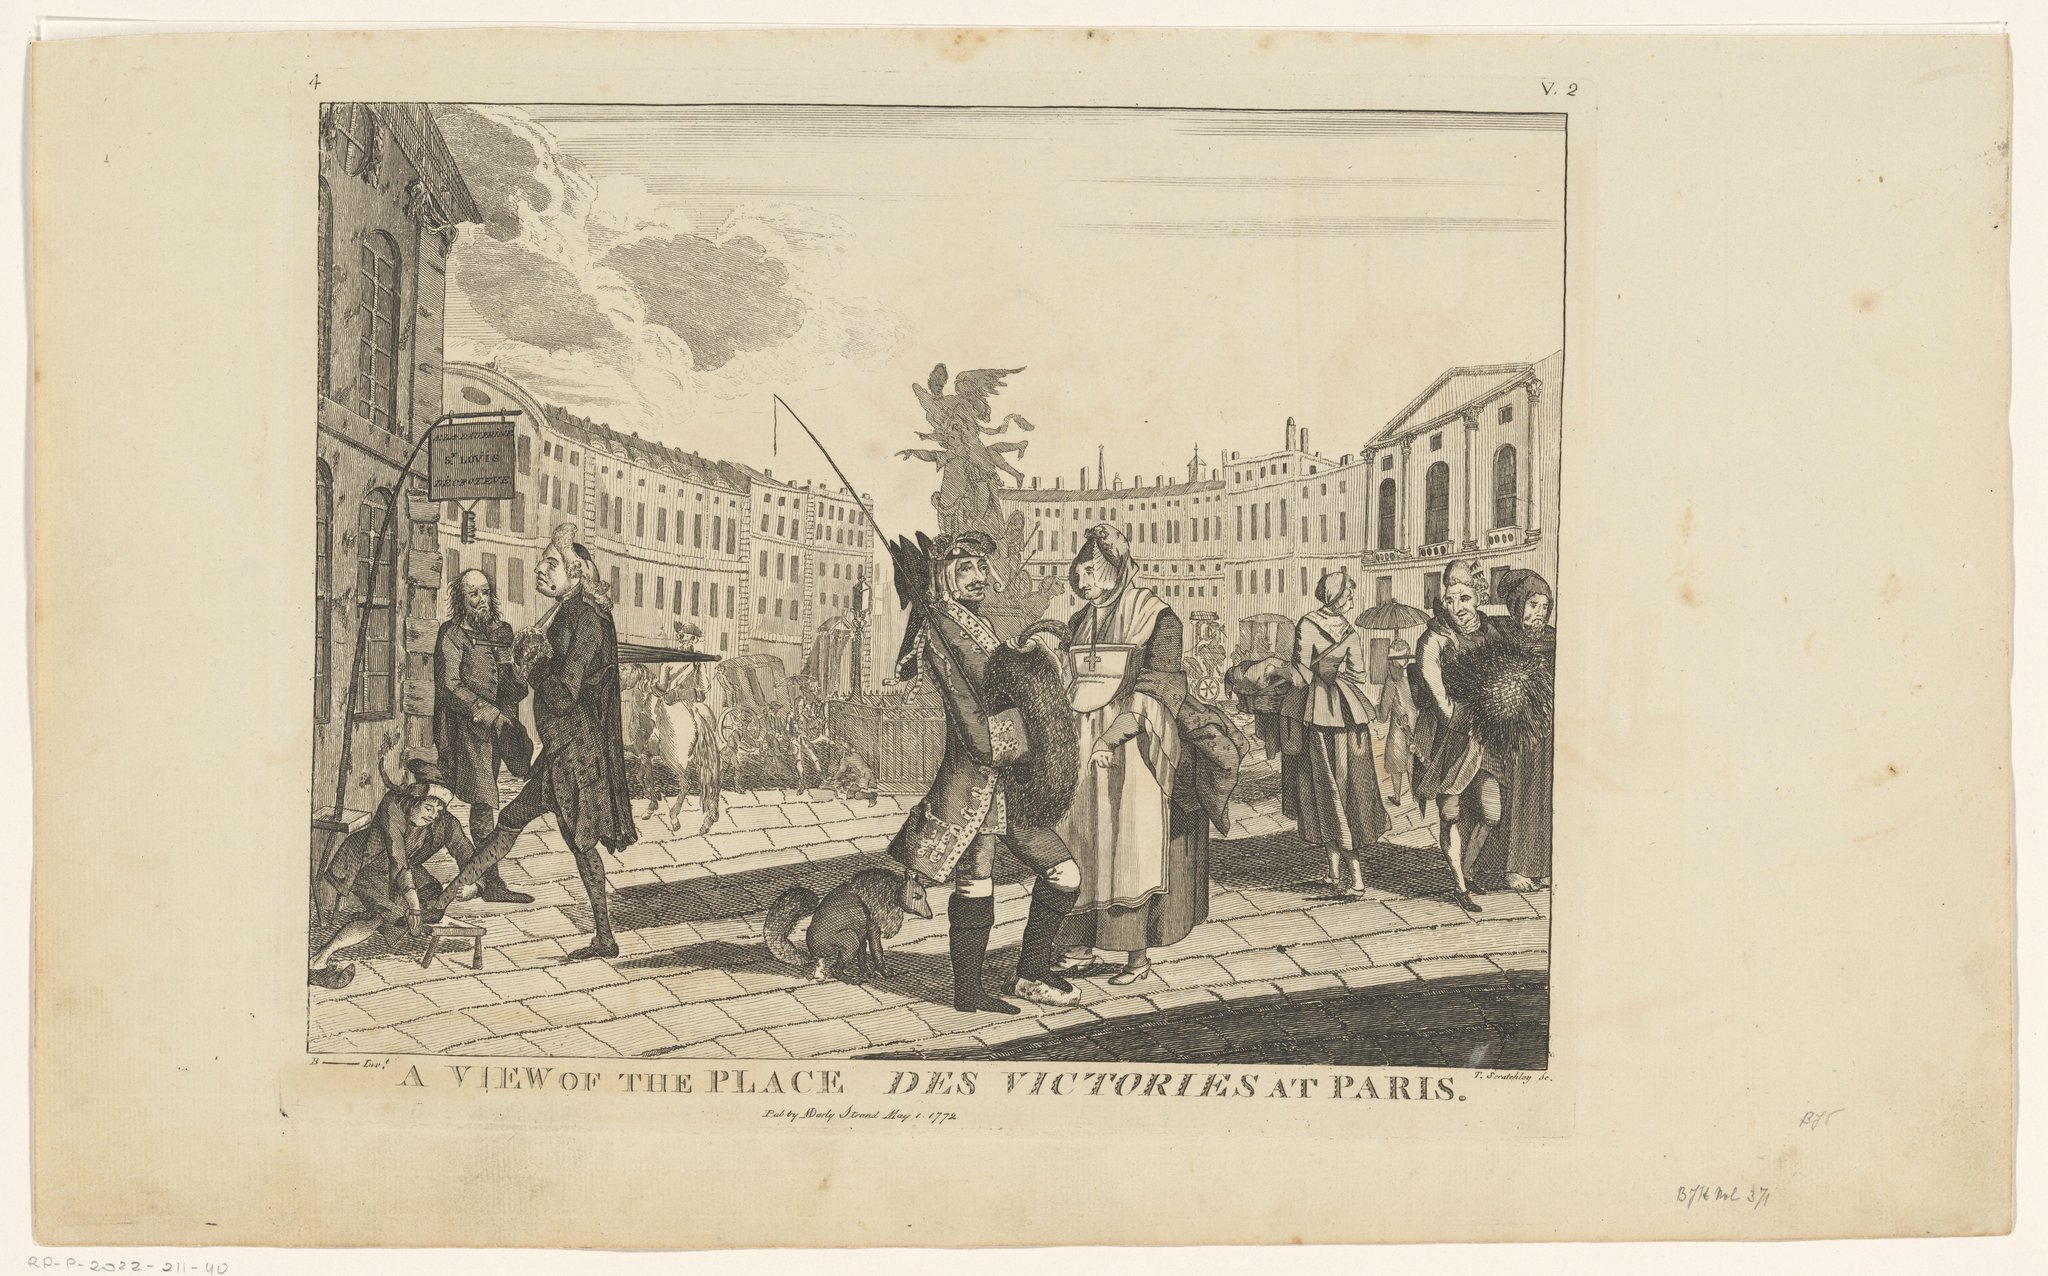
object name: cartoon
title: A View of the Places des Victories at Paris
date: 1772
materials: paper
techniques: etching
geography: london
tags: accessories ~ shoes, e.g. insole, shoehorn, shoe-polish, caricatures (human types), europeans: french (+ caricatured), street-trader, dog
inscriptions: collector's mark: Lugt 2228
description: Bedrijvigheid op het Place des Victoires in Parijs met koetsen, schoenpoetsers en bedelaars.